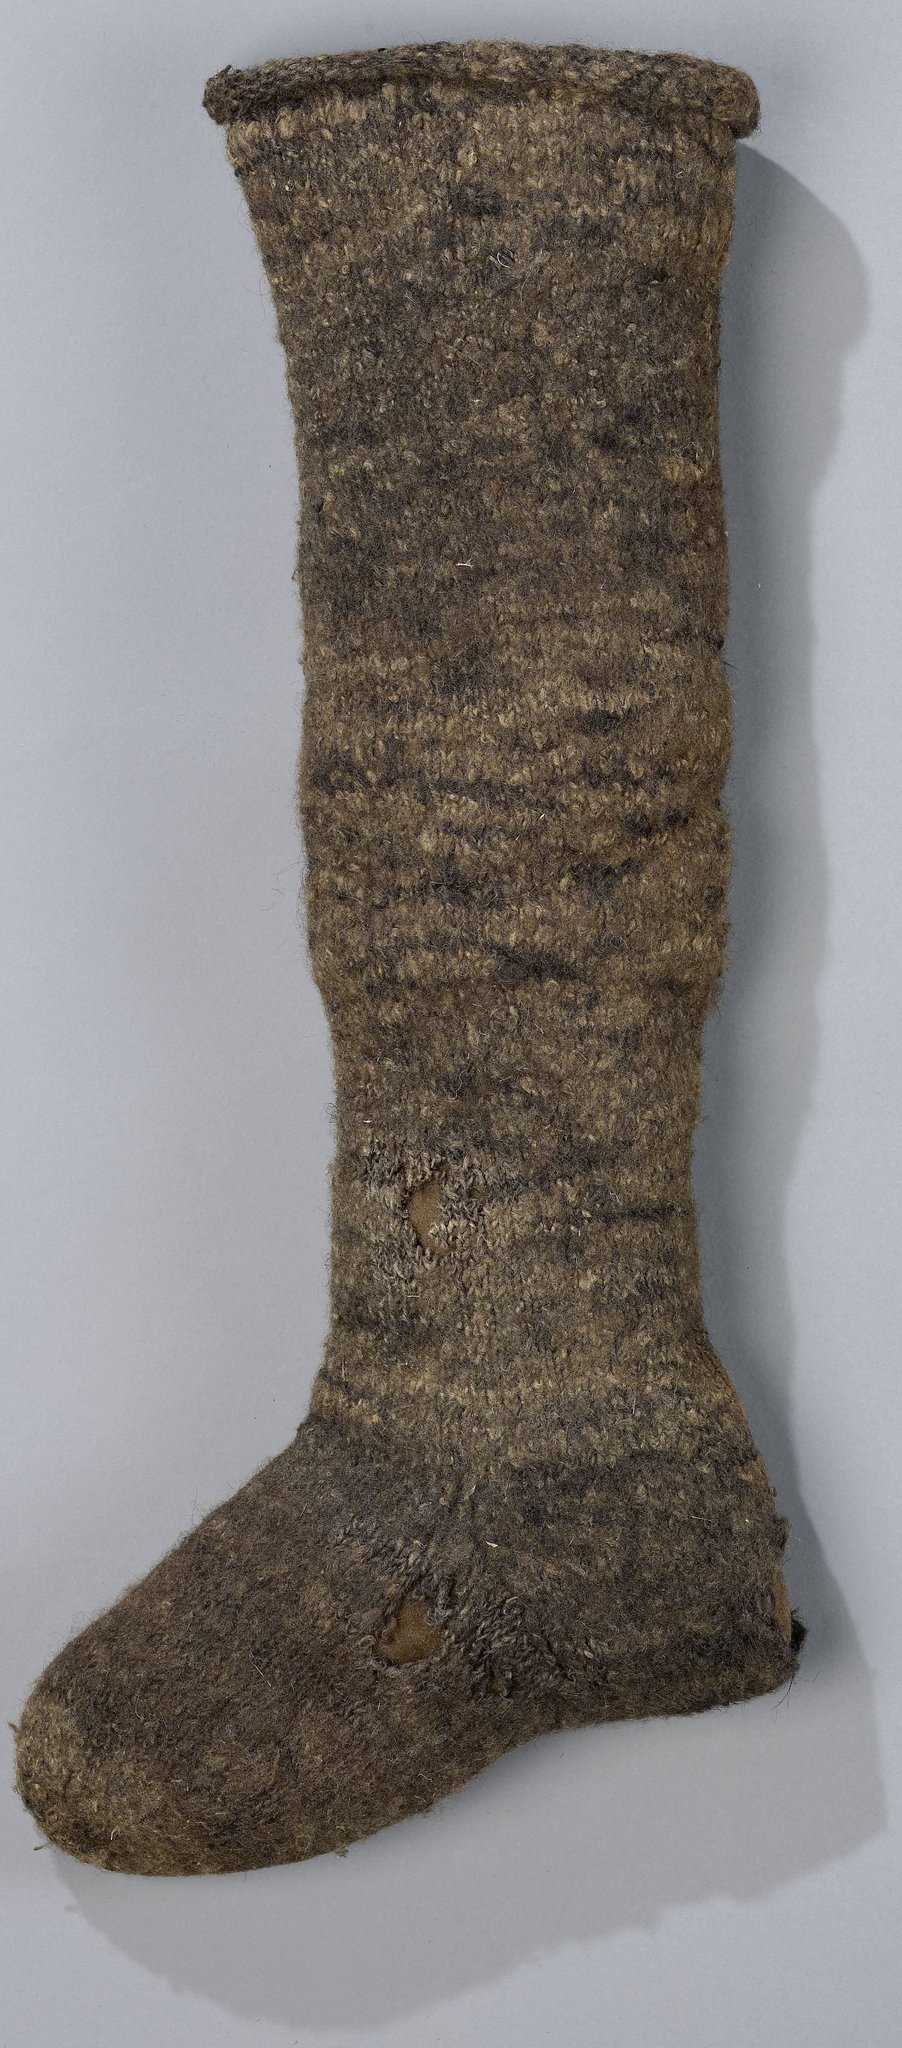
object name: kniekous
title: Kniekous, donkerbruin, grof rondgebreid, grotendeels vervilt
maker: Anonymous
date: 1740-1760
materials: wool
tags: noordse compagnie, spitsbergen, zeeuwsche uytkyck, svalbard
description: Kniekous, donkerbruin, grof rondgebreid, grotendeels vervilt. Gebreid in tricot-steek.